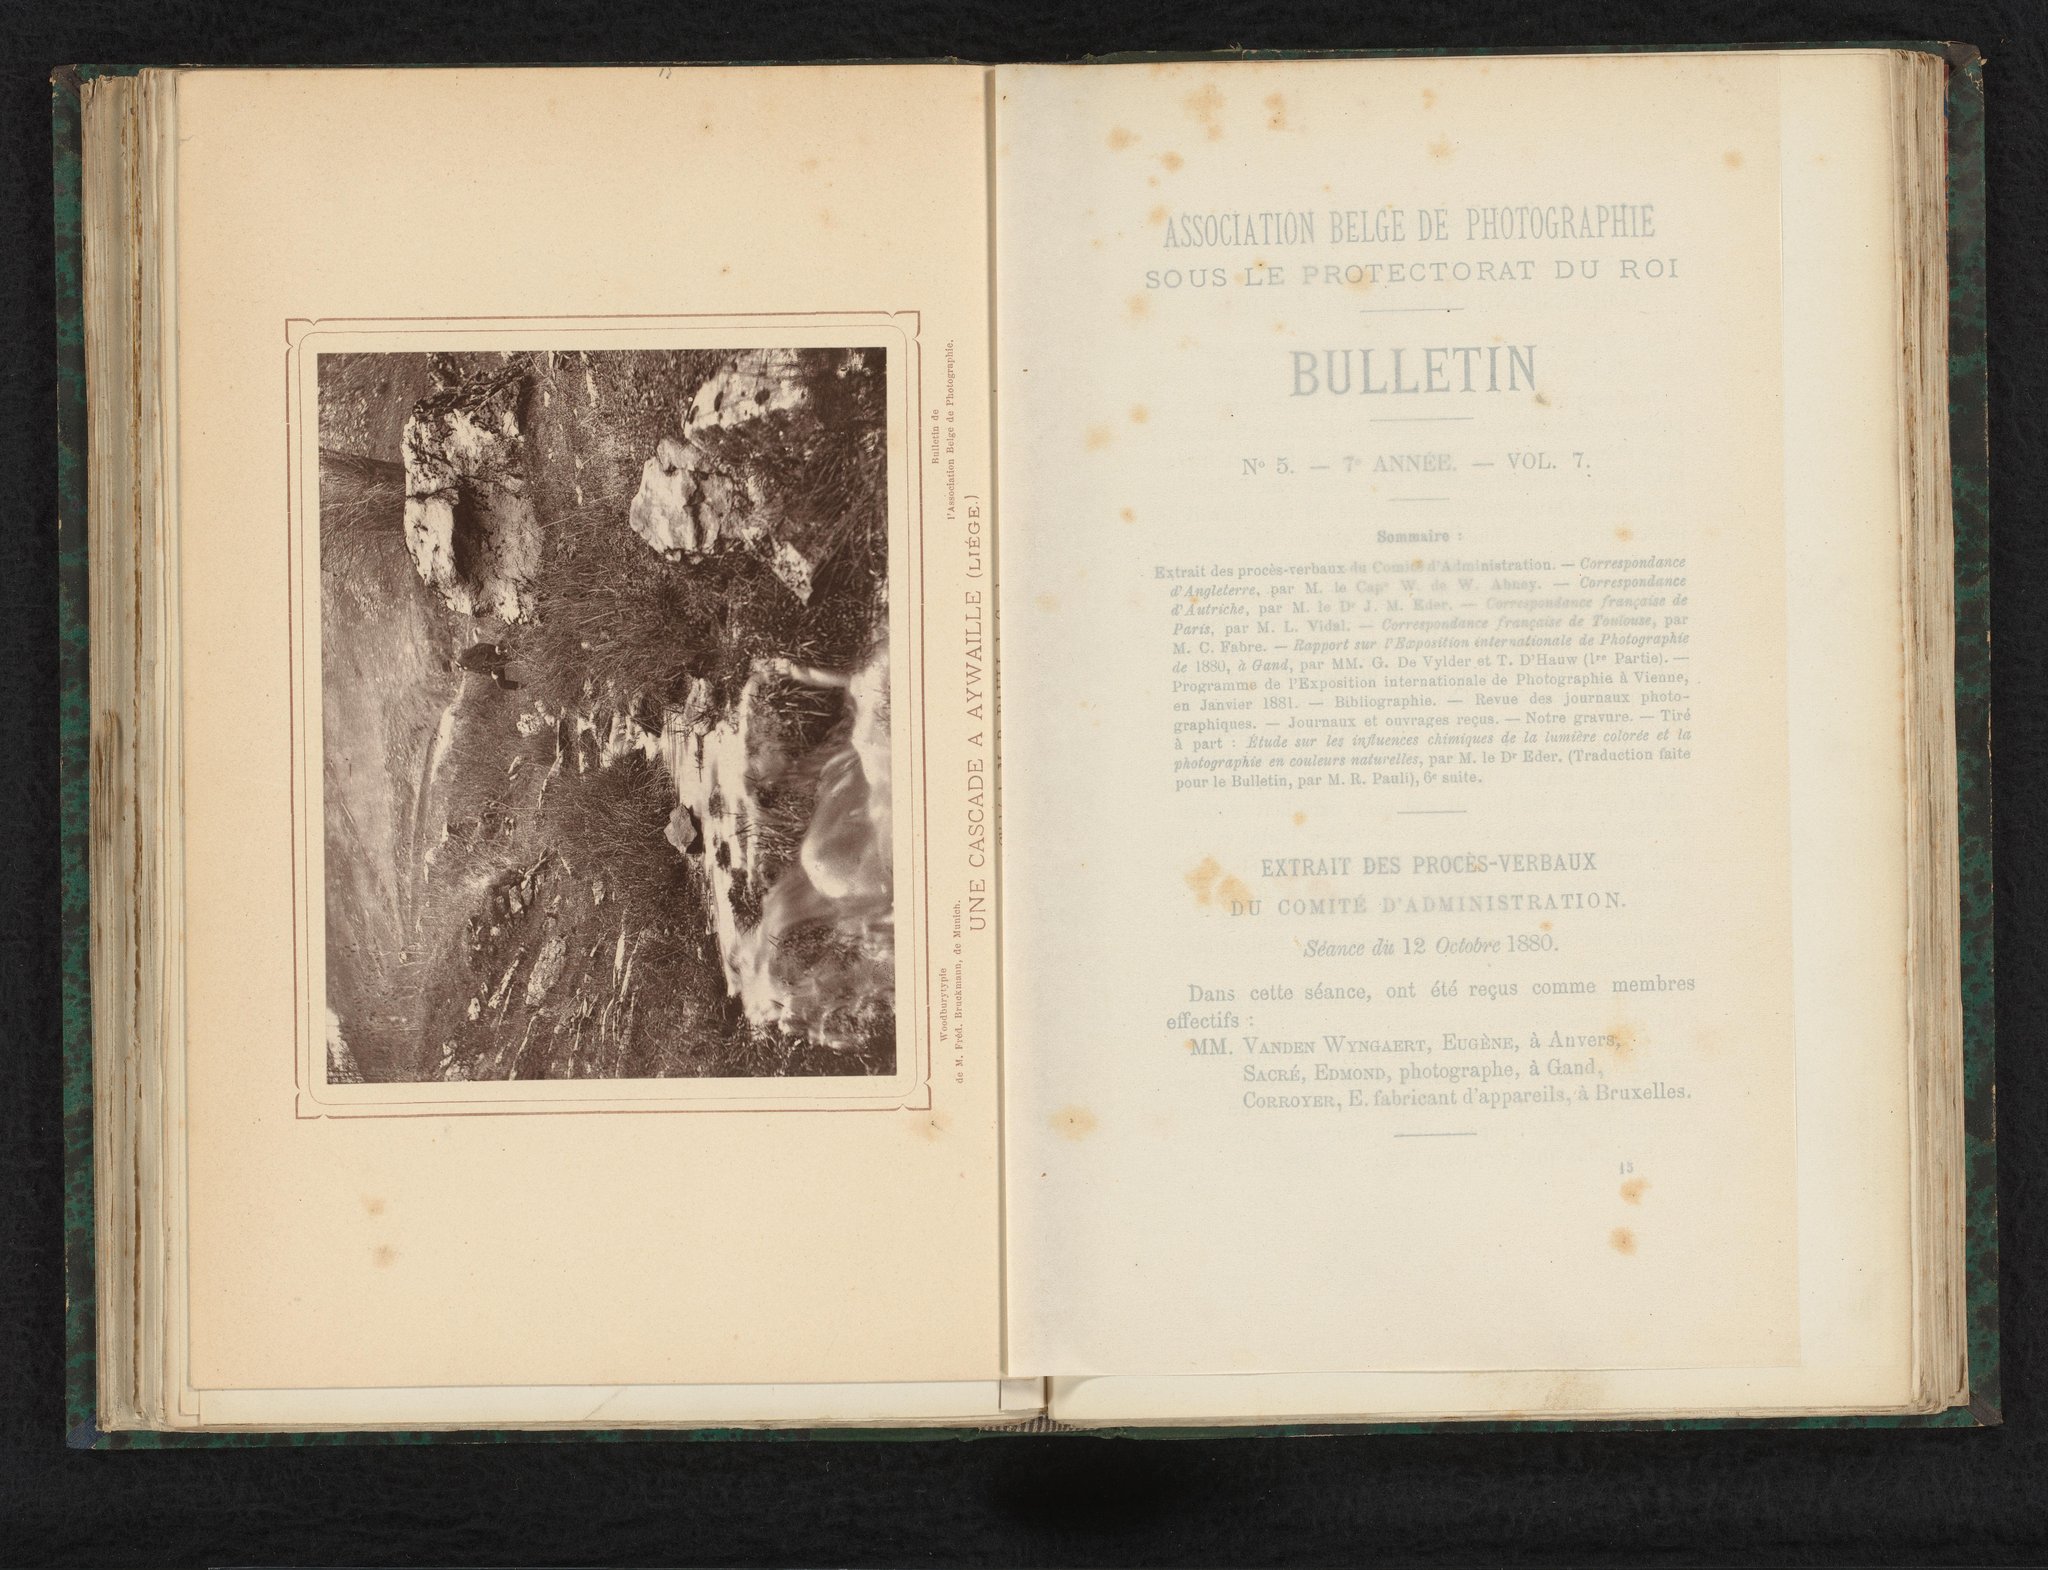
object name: page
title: Une cascade à Aywaille (Liège)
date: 1875-1880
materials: cardboard, paper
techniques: woodburytype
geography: aywaille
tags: waterfall